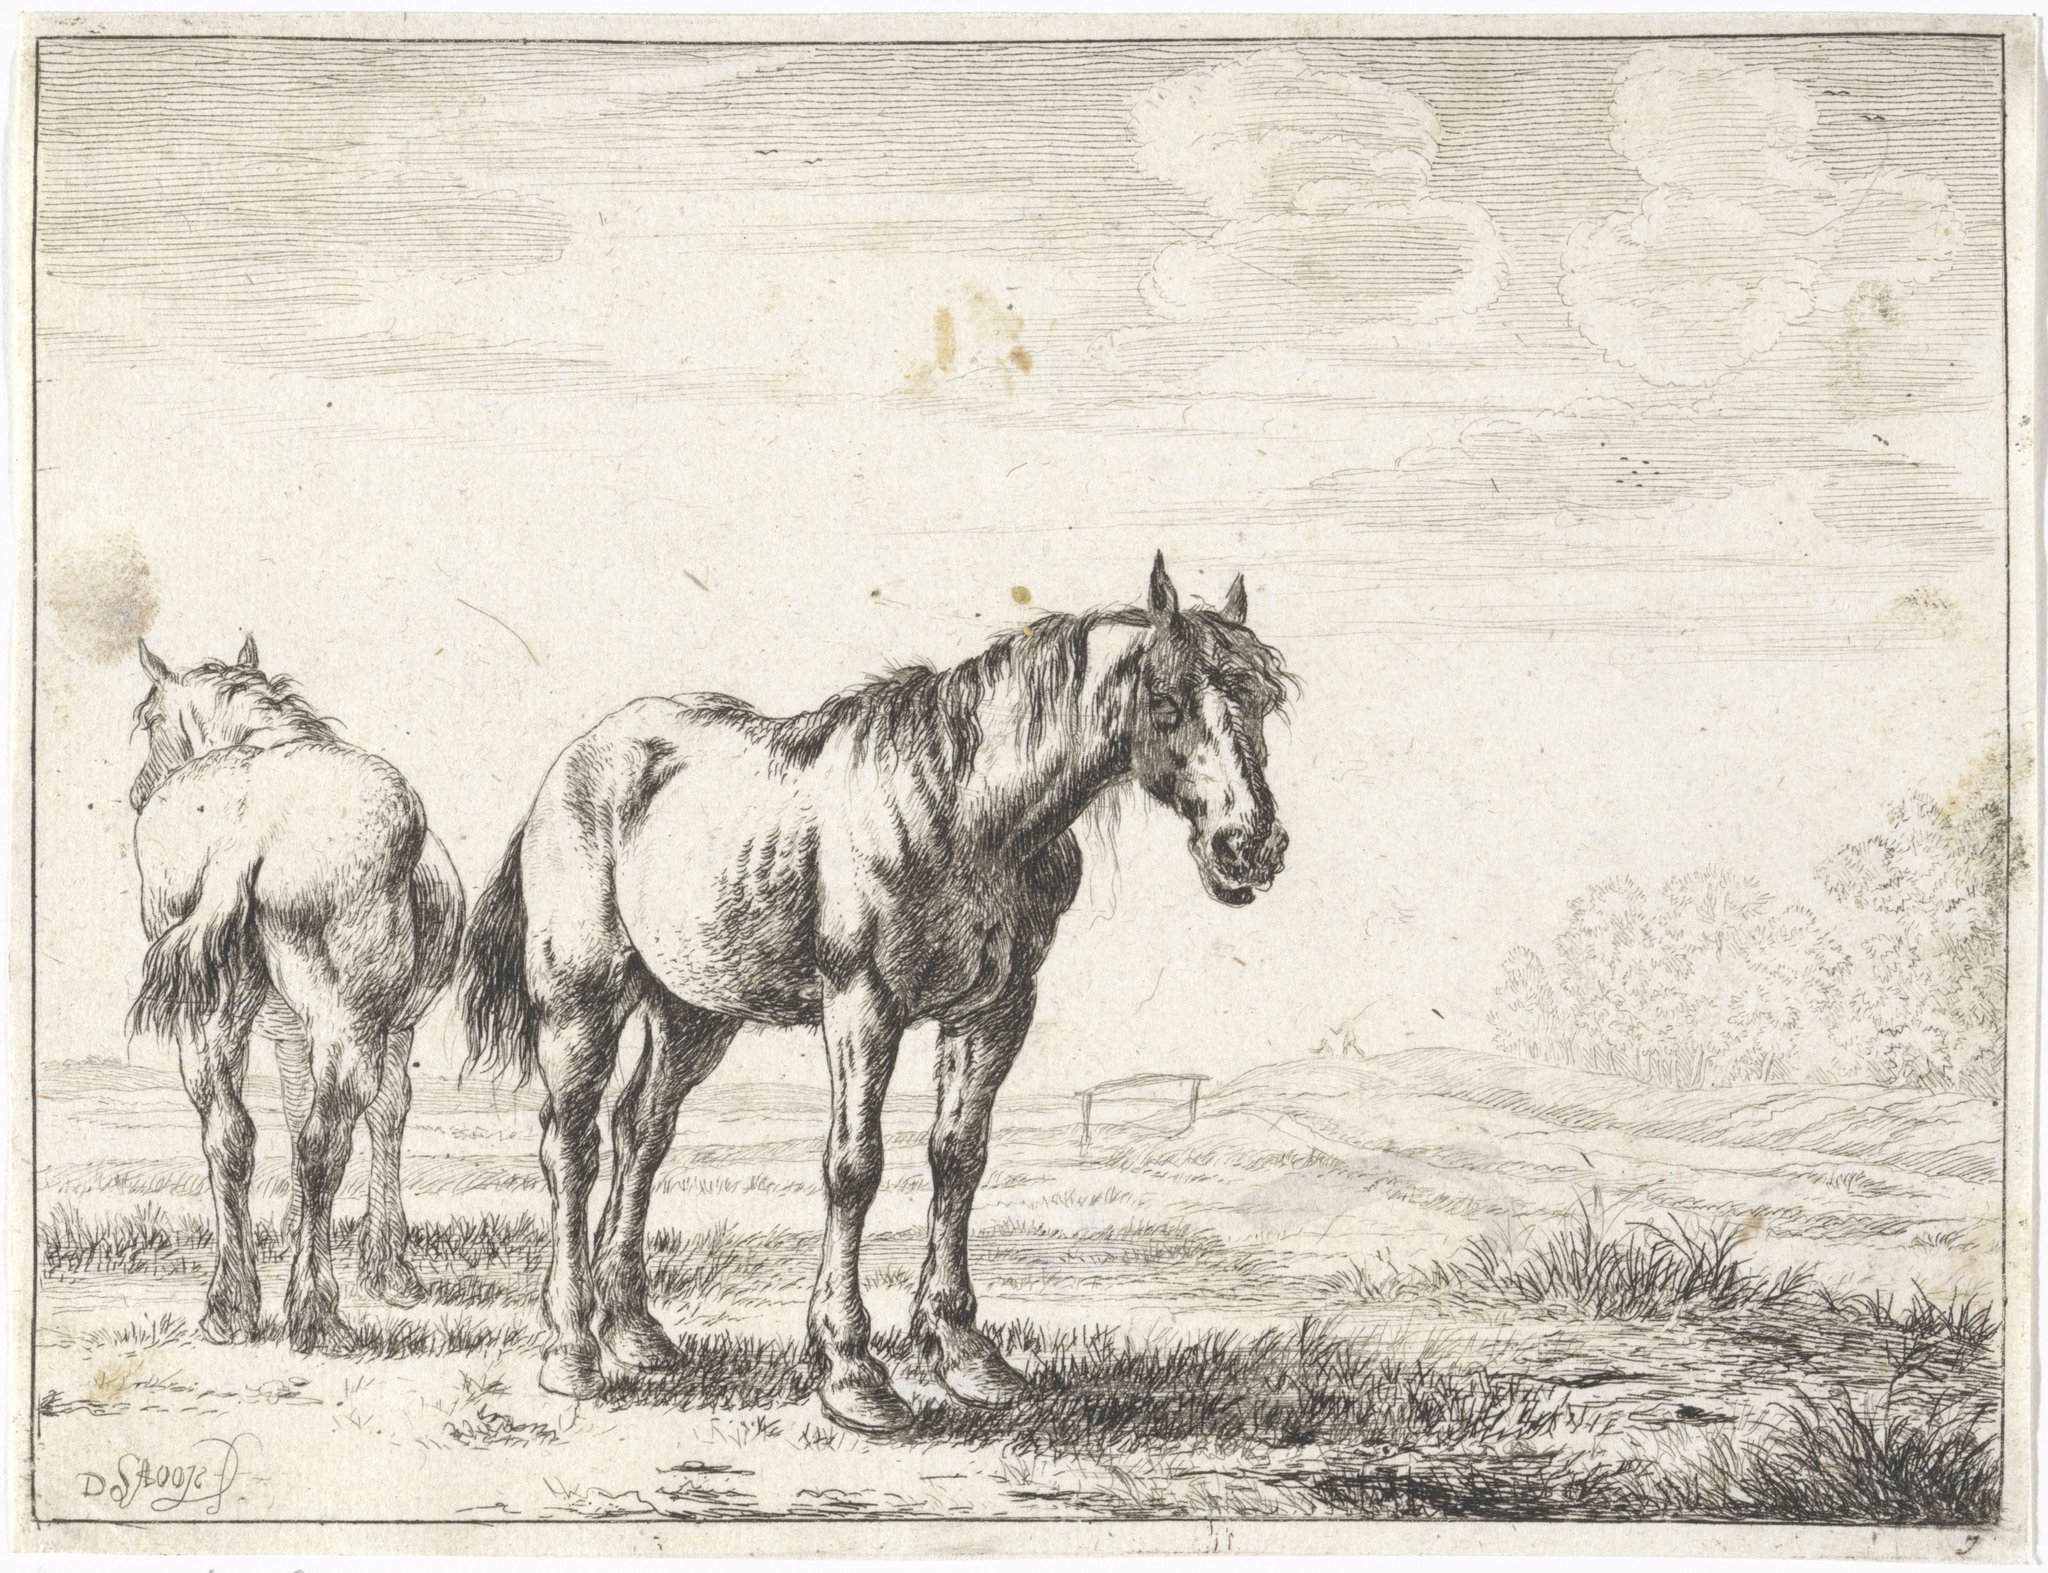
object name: print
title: Paarden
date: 1651-1706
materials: paper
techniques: etching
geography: utrecht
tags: horse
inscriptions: collector's mark: Lugt 240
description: Twee paarden in een landschap. Het paard link van achteren gezien.